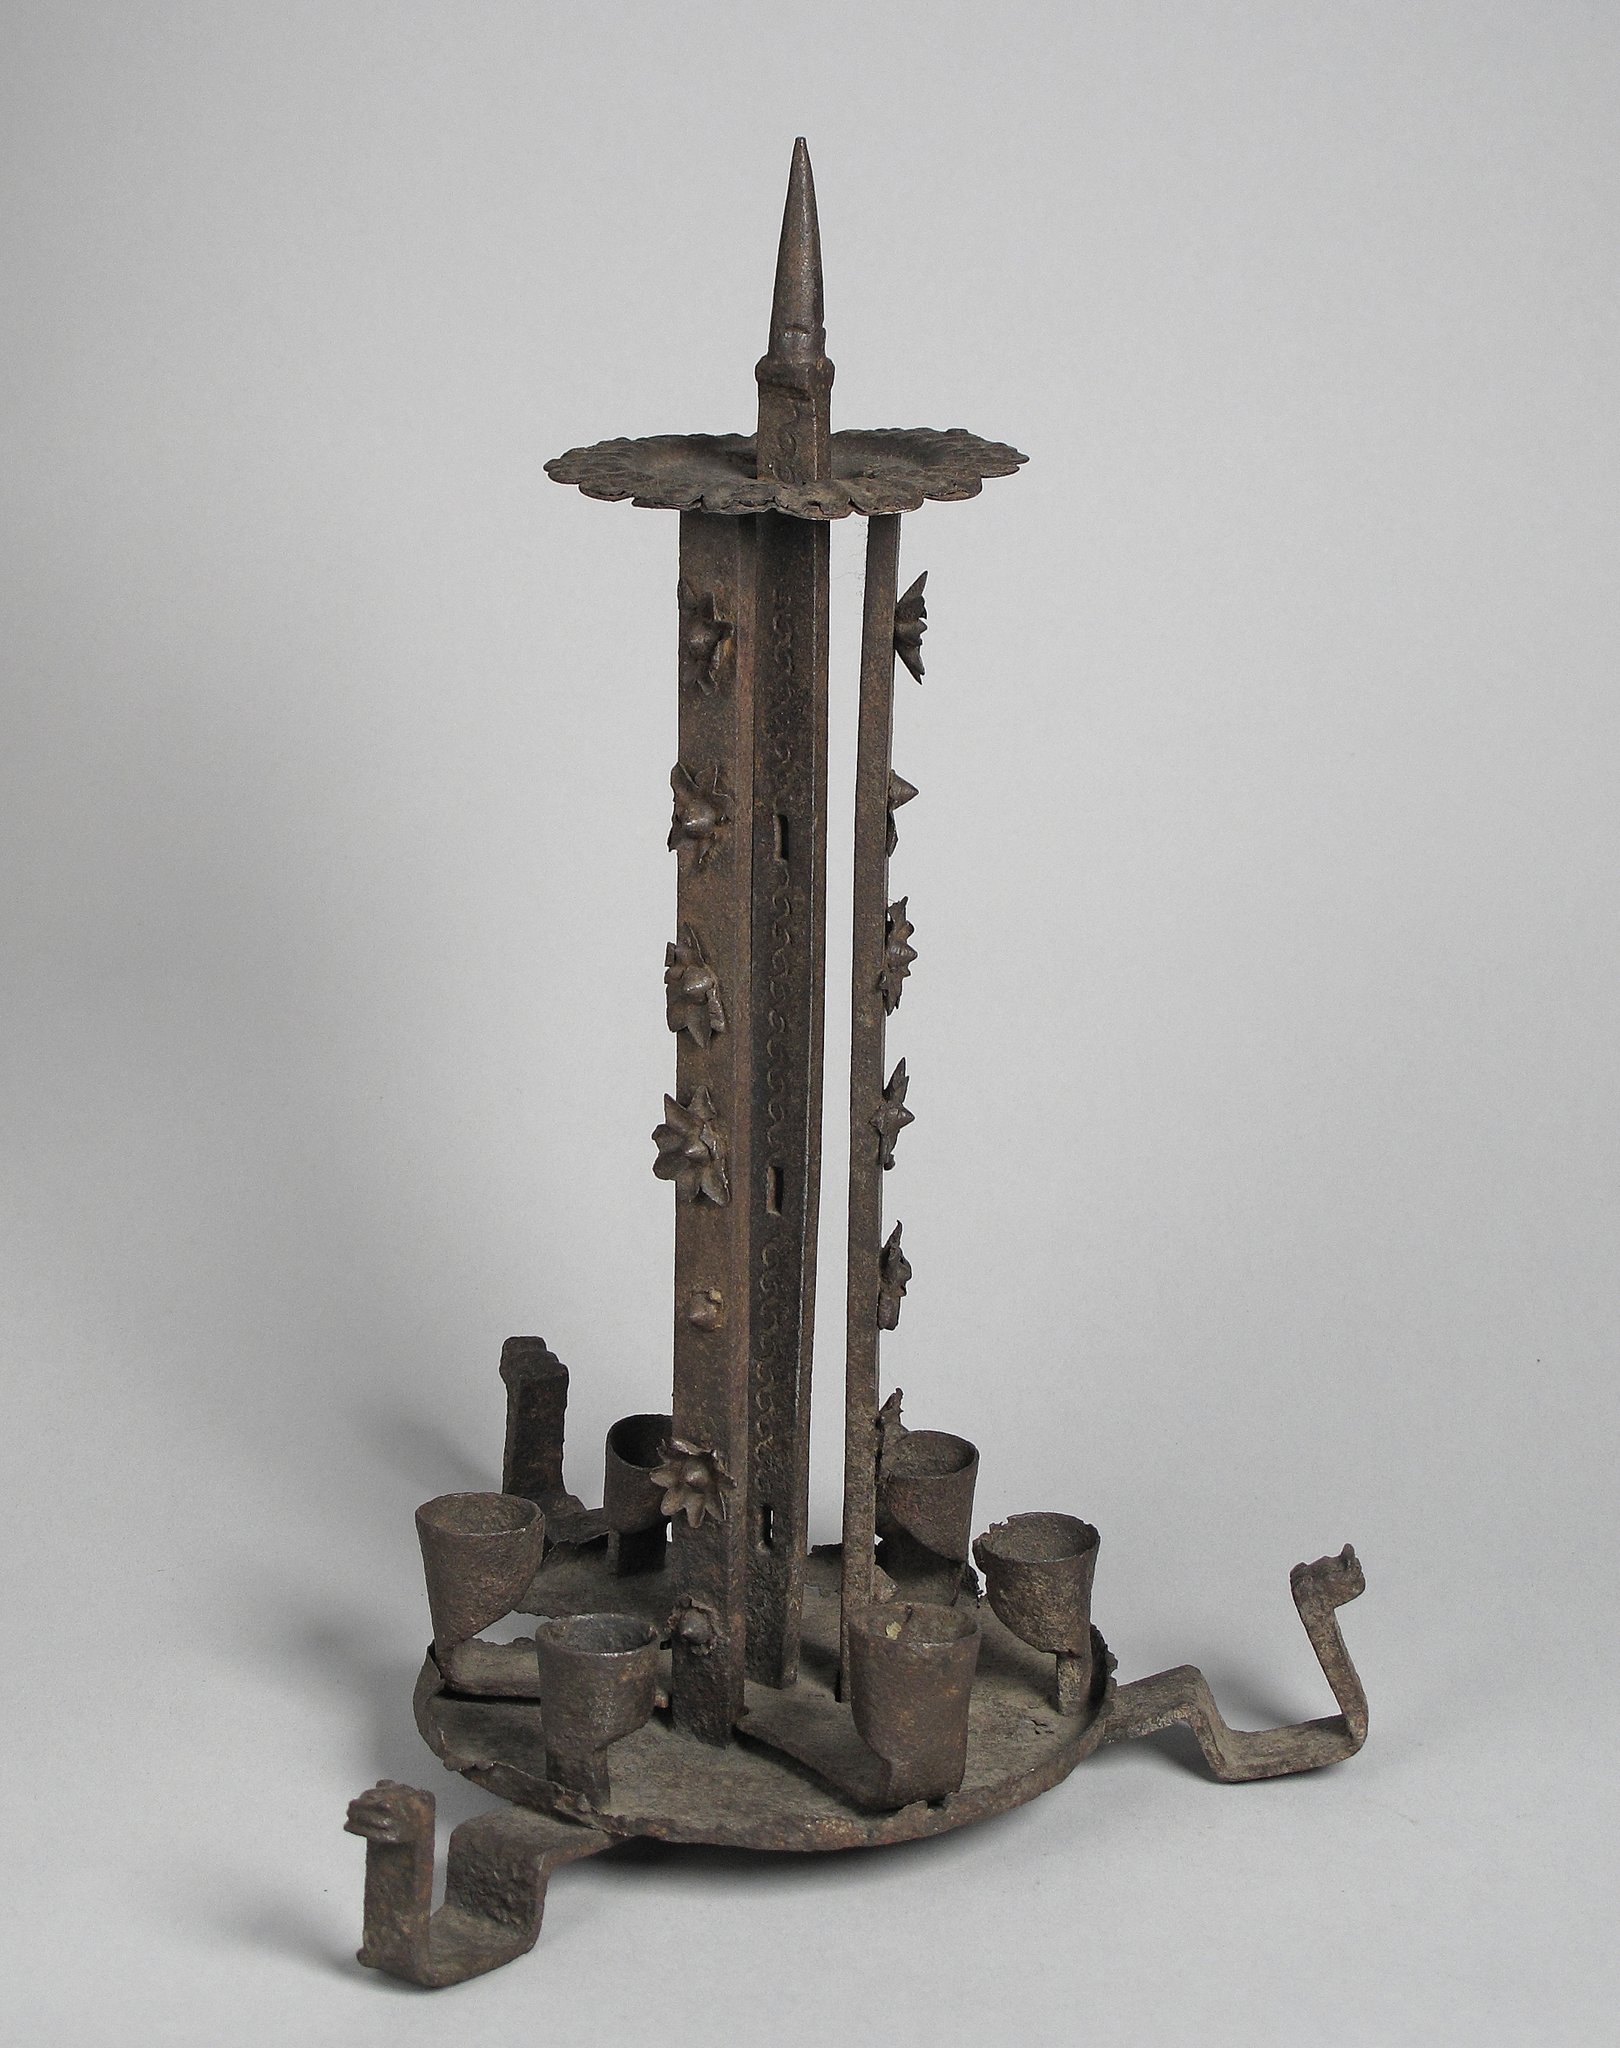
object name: candlestick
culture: european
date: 1401-1600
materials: iron